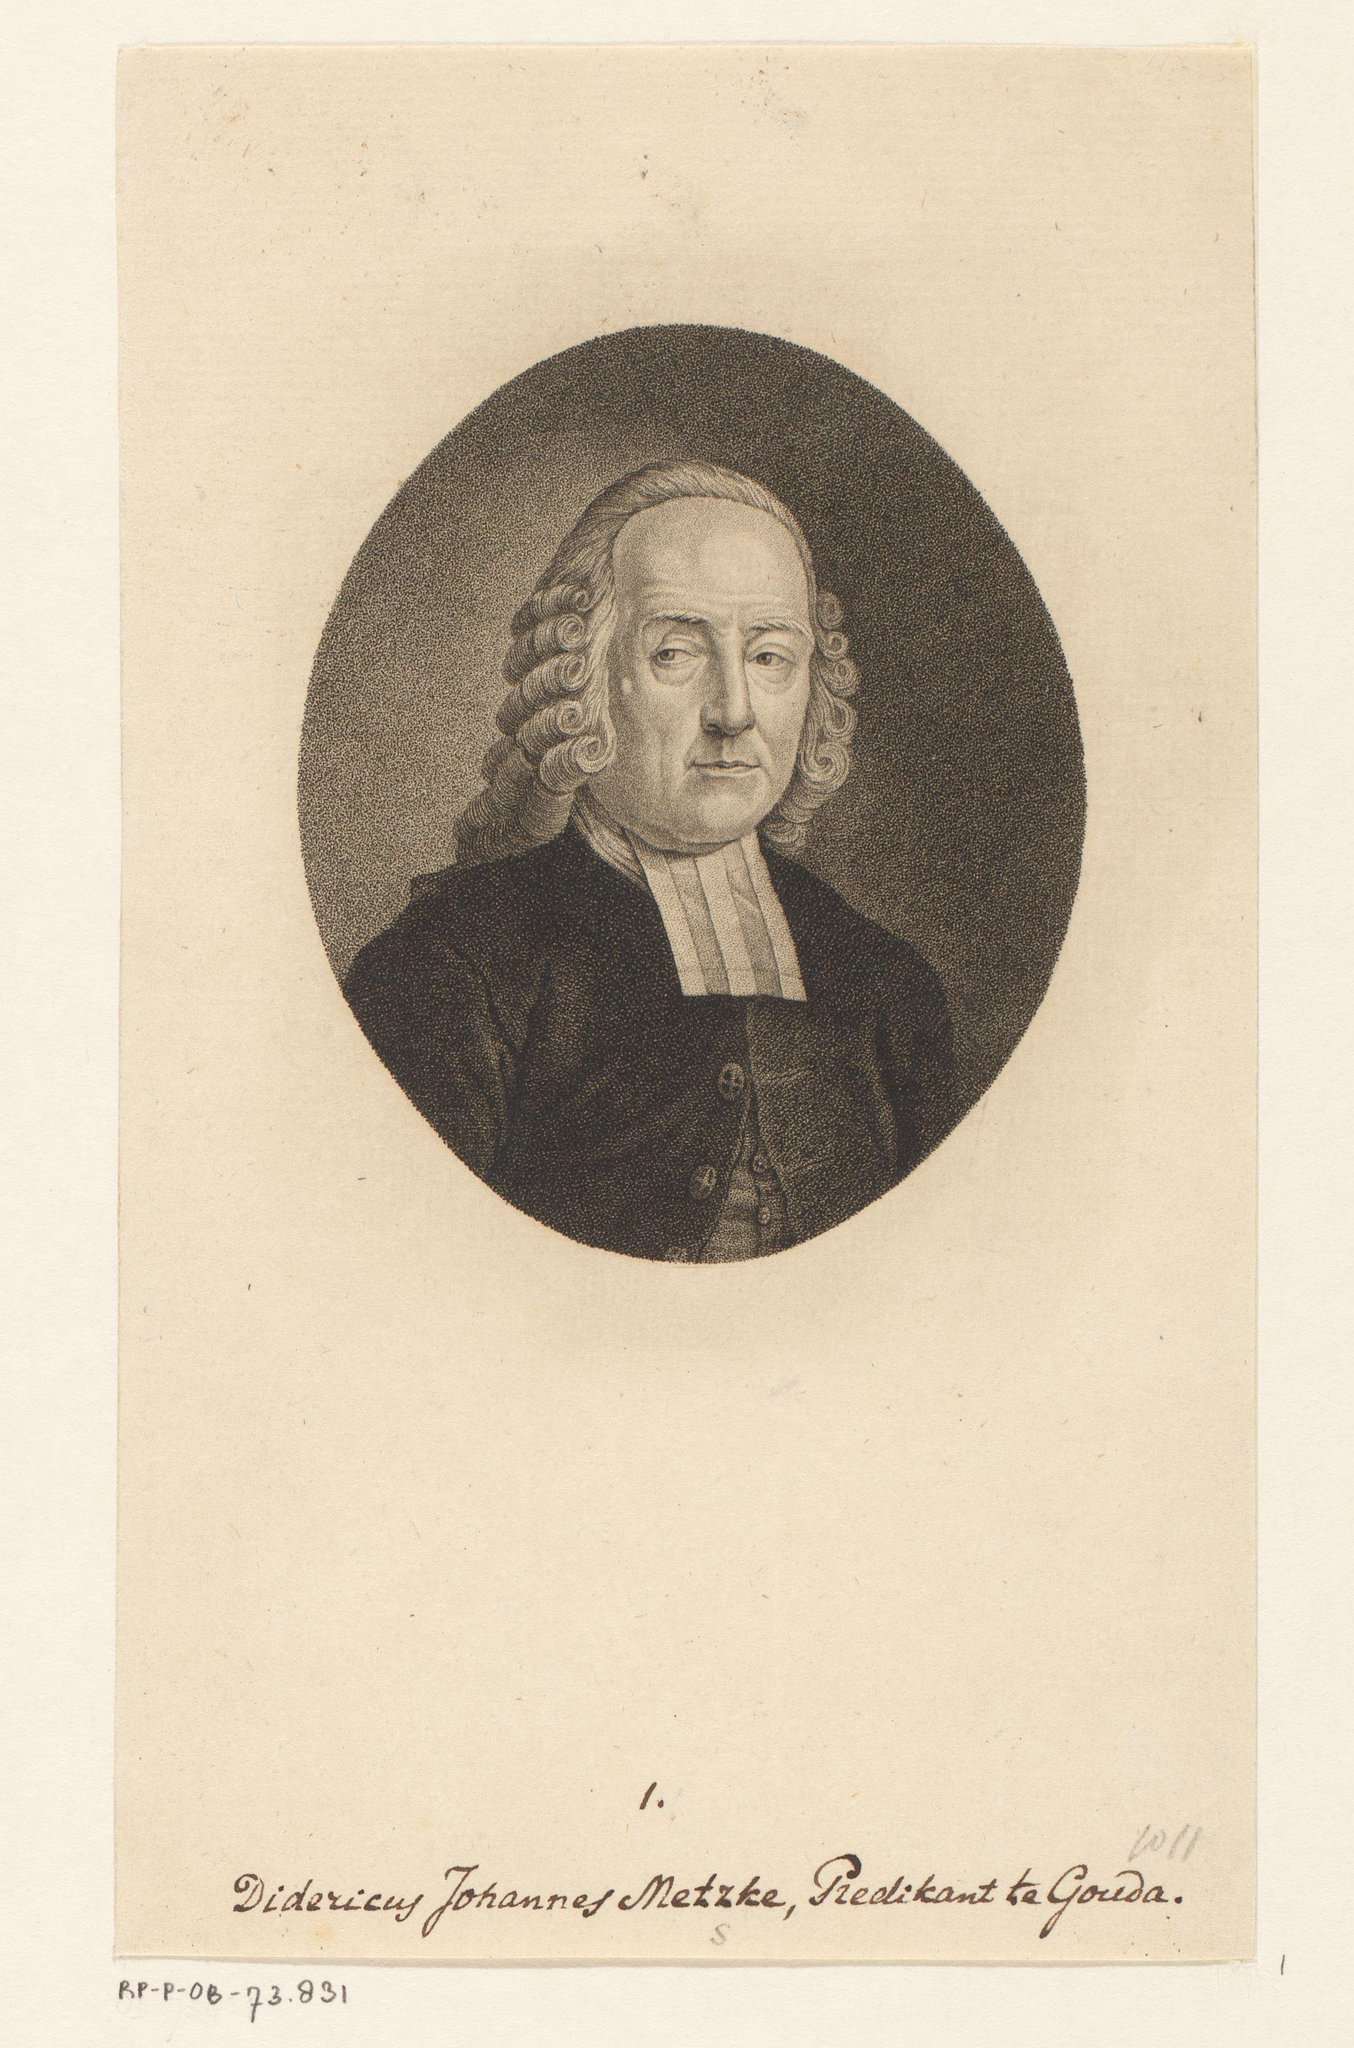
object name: print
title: Portret van Dirk Jan Metske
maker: hendrik roosing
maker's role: print maker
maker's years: 1763-1826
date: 1796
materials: paper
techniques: stippled etching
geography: rotterdam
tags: dirk jan metske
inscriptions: inscription: ‘1. / Didericus Johannes Metzke, Predikant te Gouda.’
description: Portret van Dirk Jan Metske, predikant in Gouda. Onder het portret een plaquette met zijn naam en een vers ter gelegenheid van zijn overlijden.